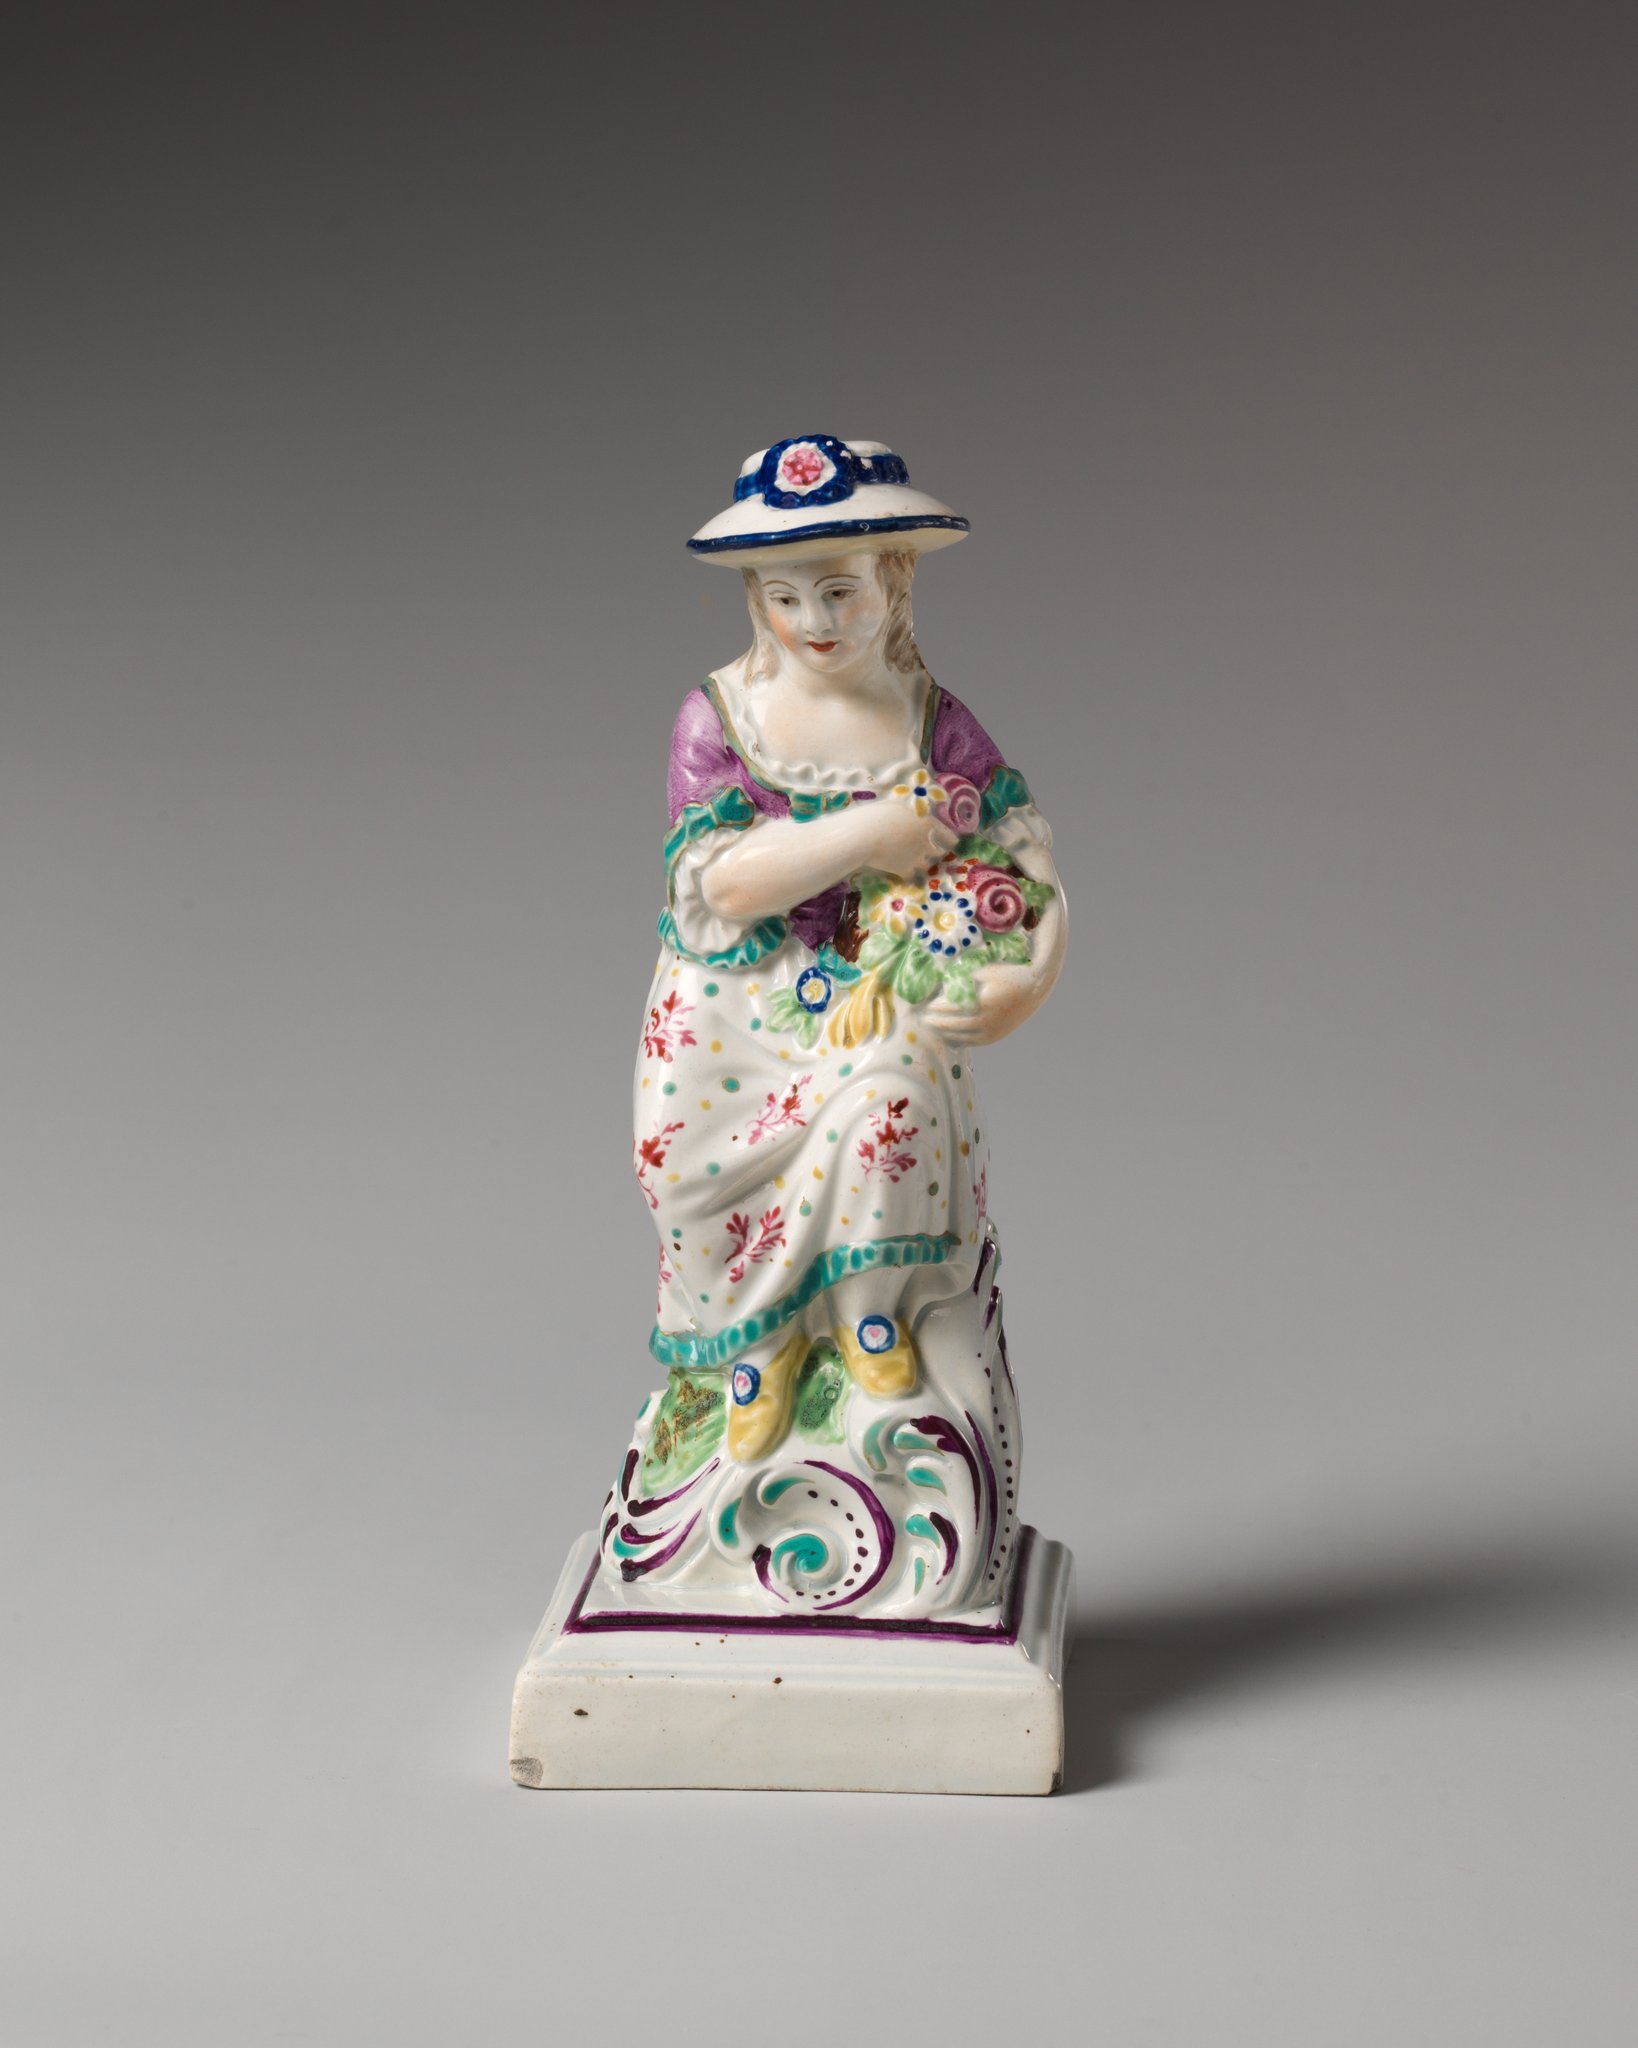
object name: figure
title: Spring (part of a set of four)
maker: neale & co.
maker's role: maker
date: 1780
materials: earthenware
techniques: enamel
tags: portraits,women,flowers